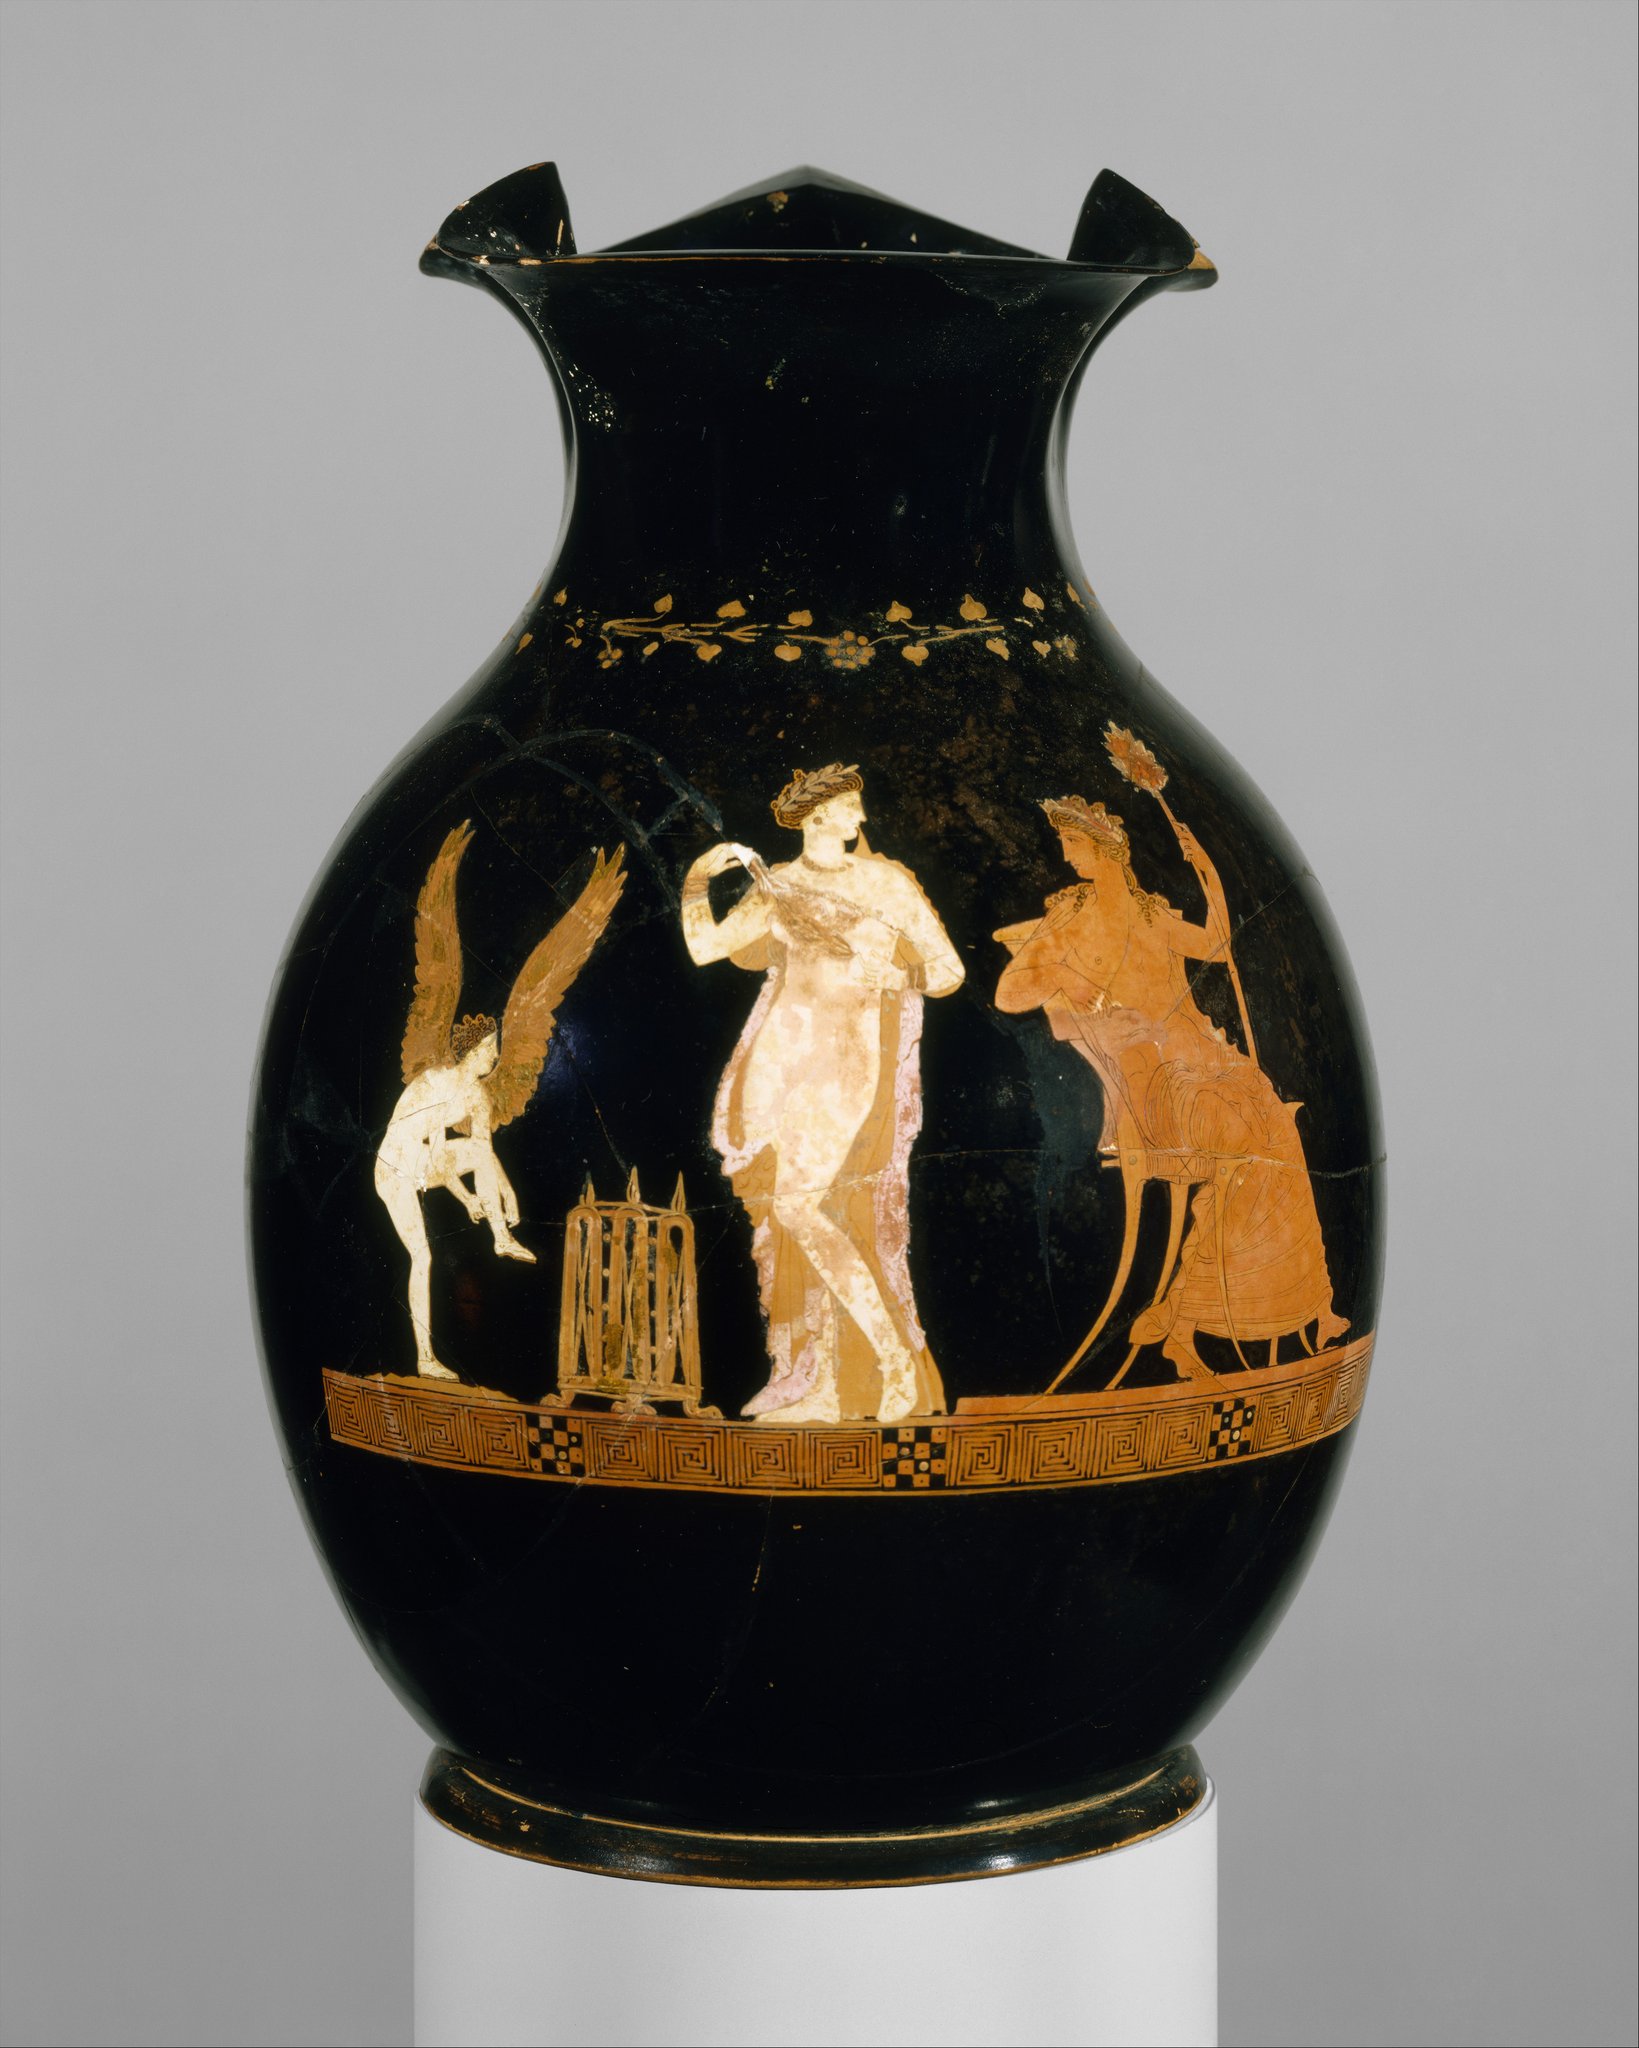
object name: oinochoe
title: Terracotta oinochoe (jug)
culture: greek, attic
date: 367-335 BCE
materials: terracotta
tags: dionysus,eros